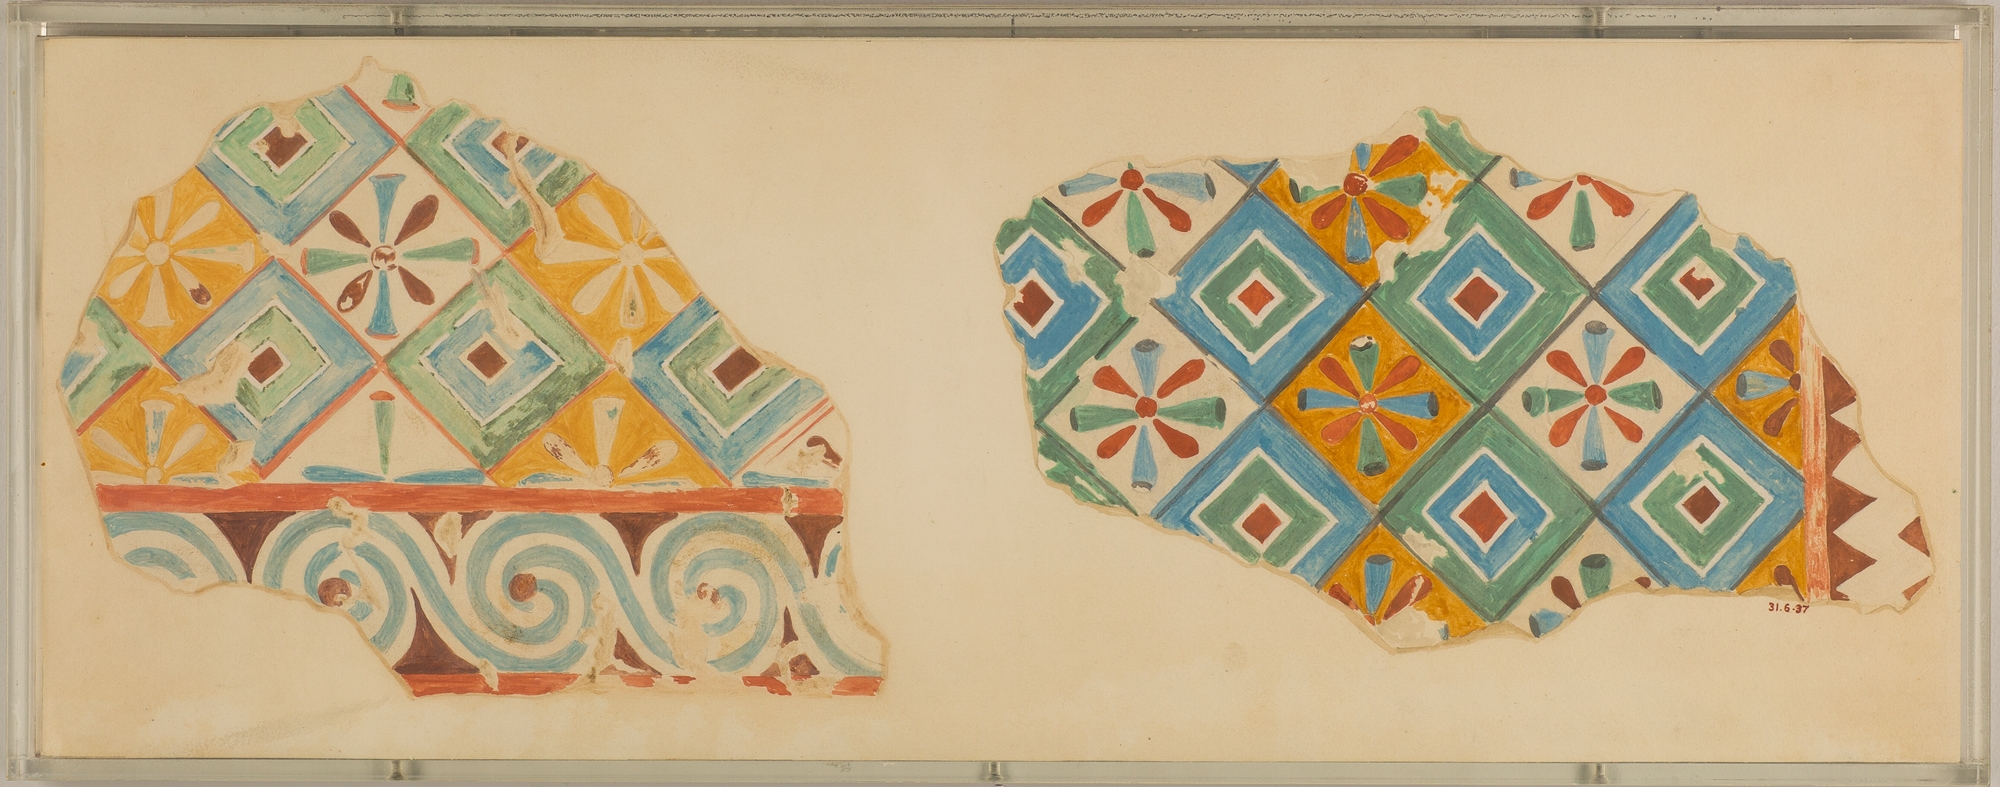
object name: facsimile, ceiling pattern, senenmut tt 71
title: Two Fragments of Ceiling Patterns, Tomb of Senenmut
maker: nina de garis davies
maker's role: artist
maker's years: 1881-1965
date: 1479-1458 BCE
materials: paper, paint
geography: egypt